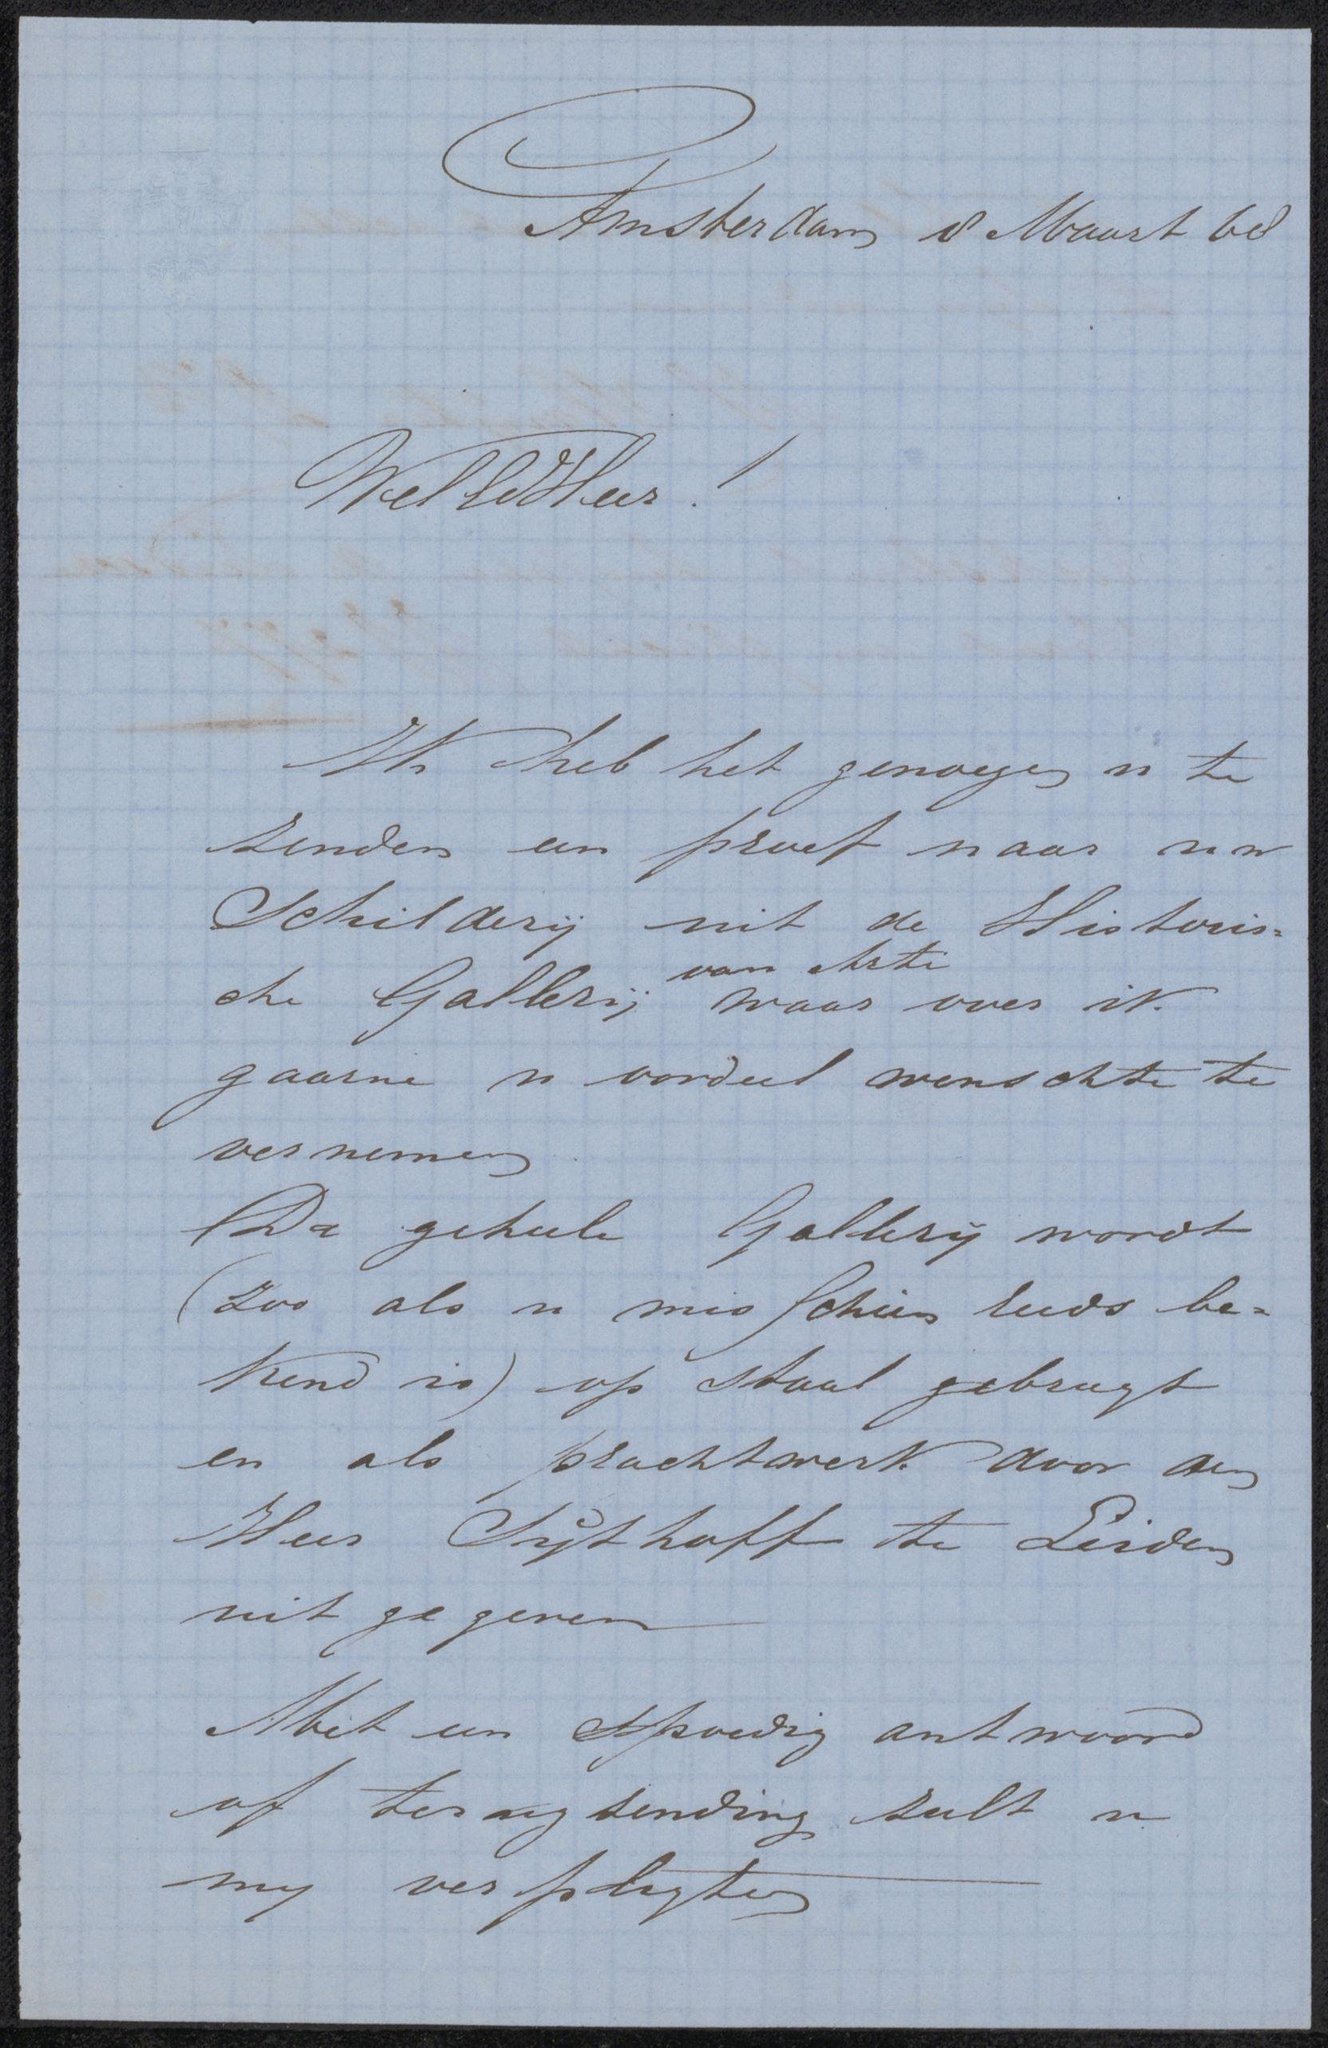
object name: letter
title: Brief aan anoniem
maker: hendrik d. jzn sluyter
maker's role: print maker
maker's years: 1839-1931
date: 1868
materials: ink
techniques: pen, writing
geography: amsterdam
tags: the hague, painter, draughtsman, jozef israëls, leiden, albertus willem sijthoff, the graphic arts, painting (including book-illumination, miniature-painting)